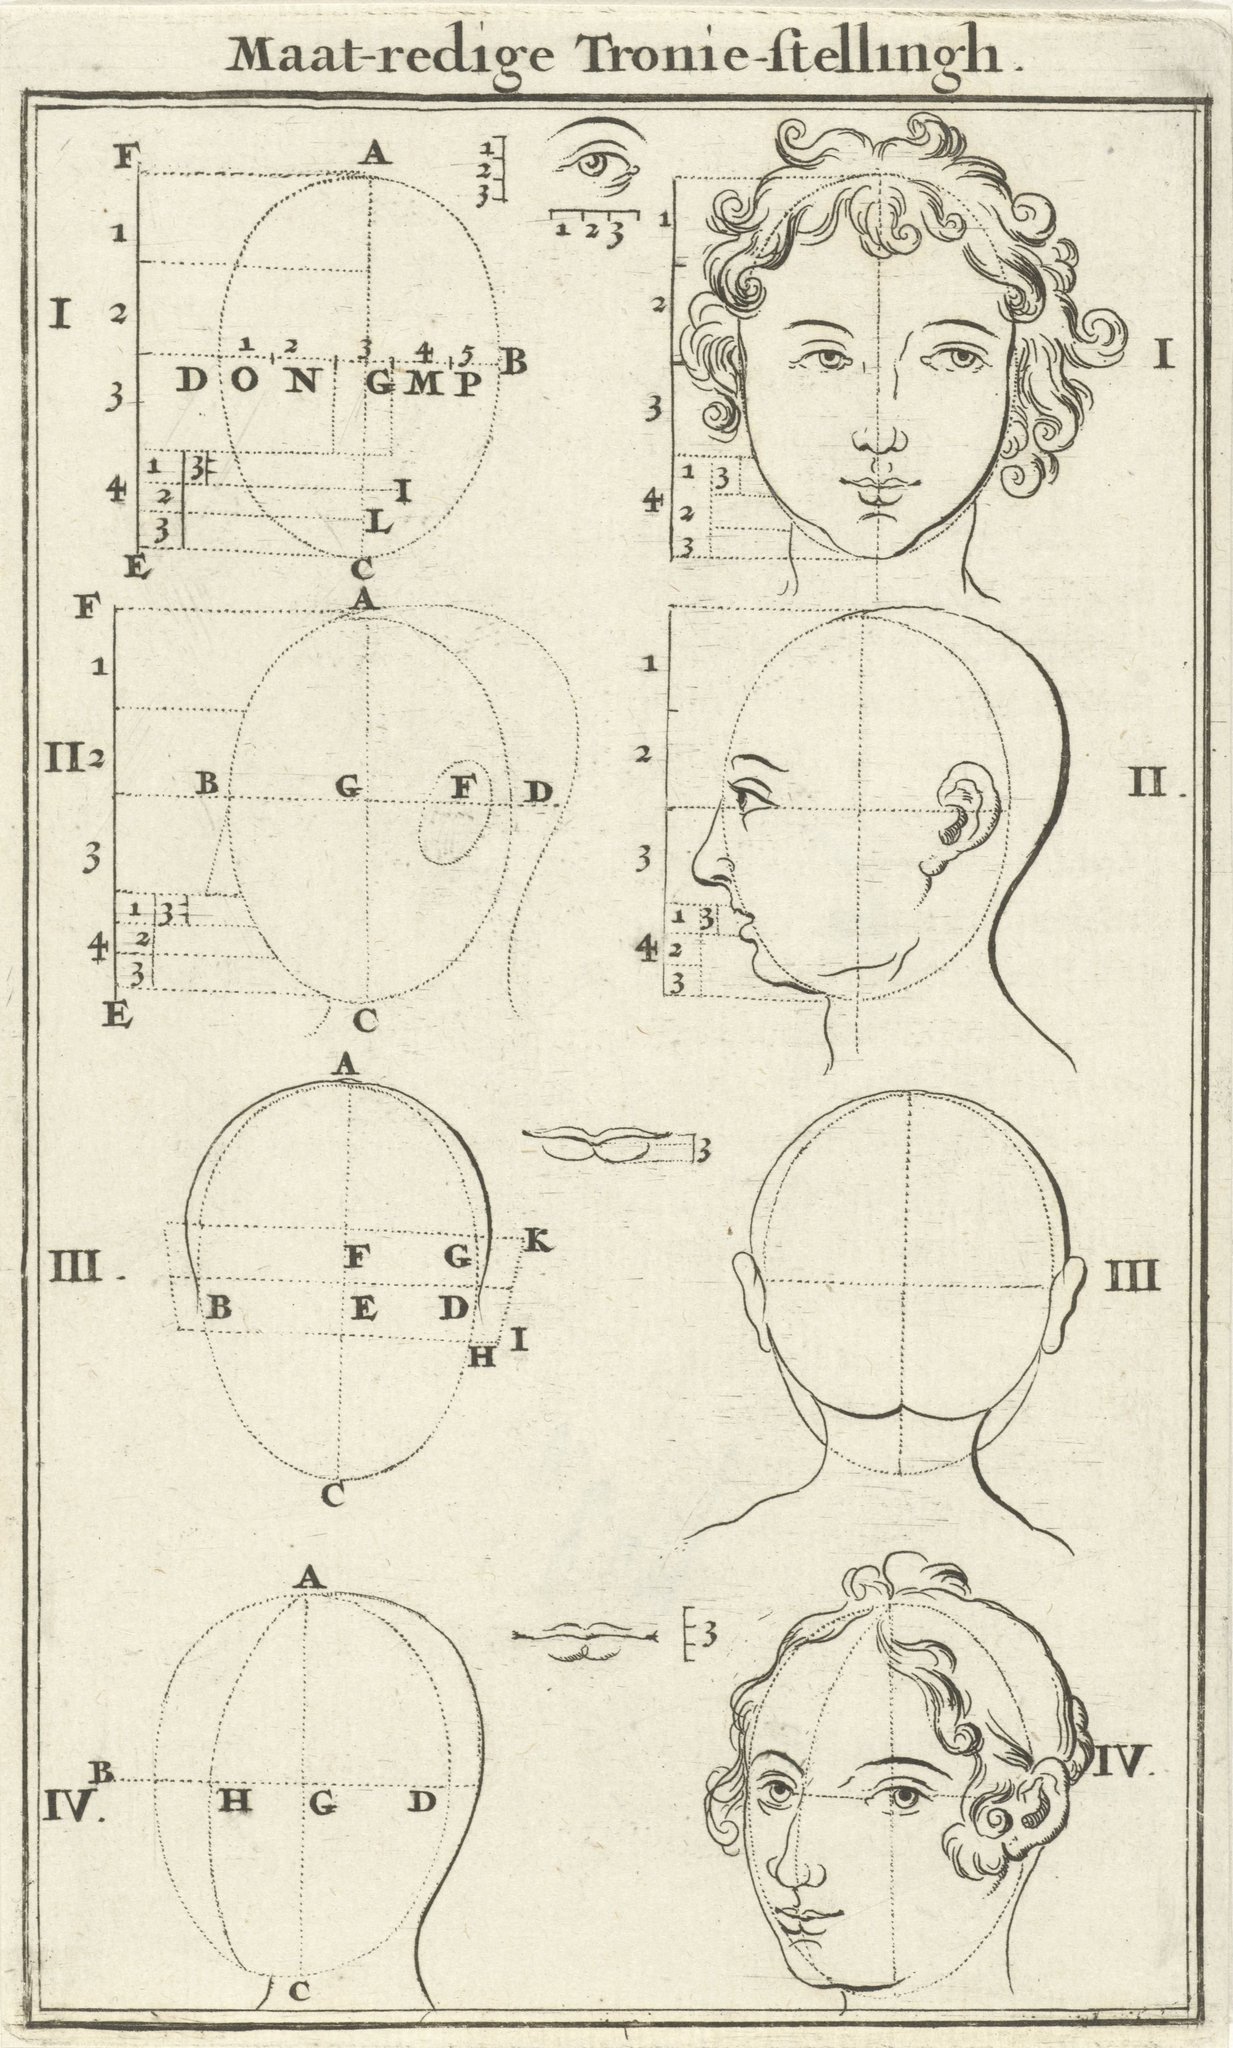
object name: book illustration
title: Maat-redige Tronie-stellingh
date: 1682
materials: paper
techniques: etching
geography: amsterdam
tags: head (human)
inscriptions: collector's mark: Lugt 2228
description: Illustratie opgenomen in: Goeree, Wilhelmus. Natuurlyk en schilderkonstig ontwerp der menschkunde, p. 223. Amsterdam: Wilhelmus Goeree (I), 1682.